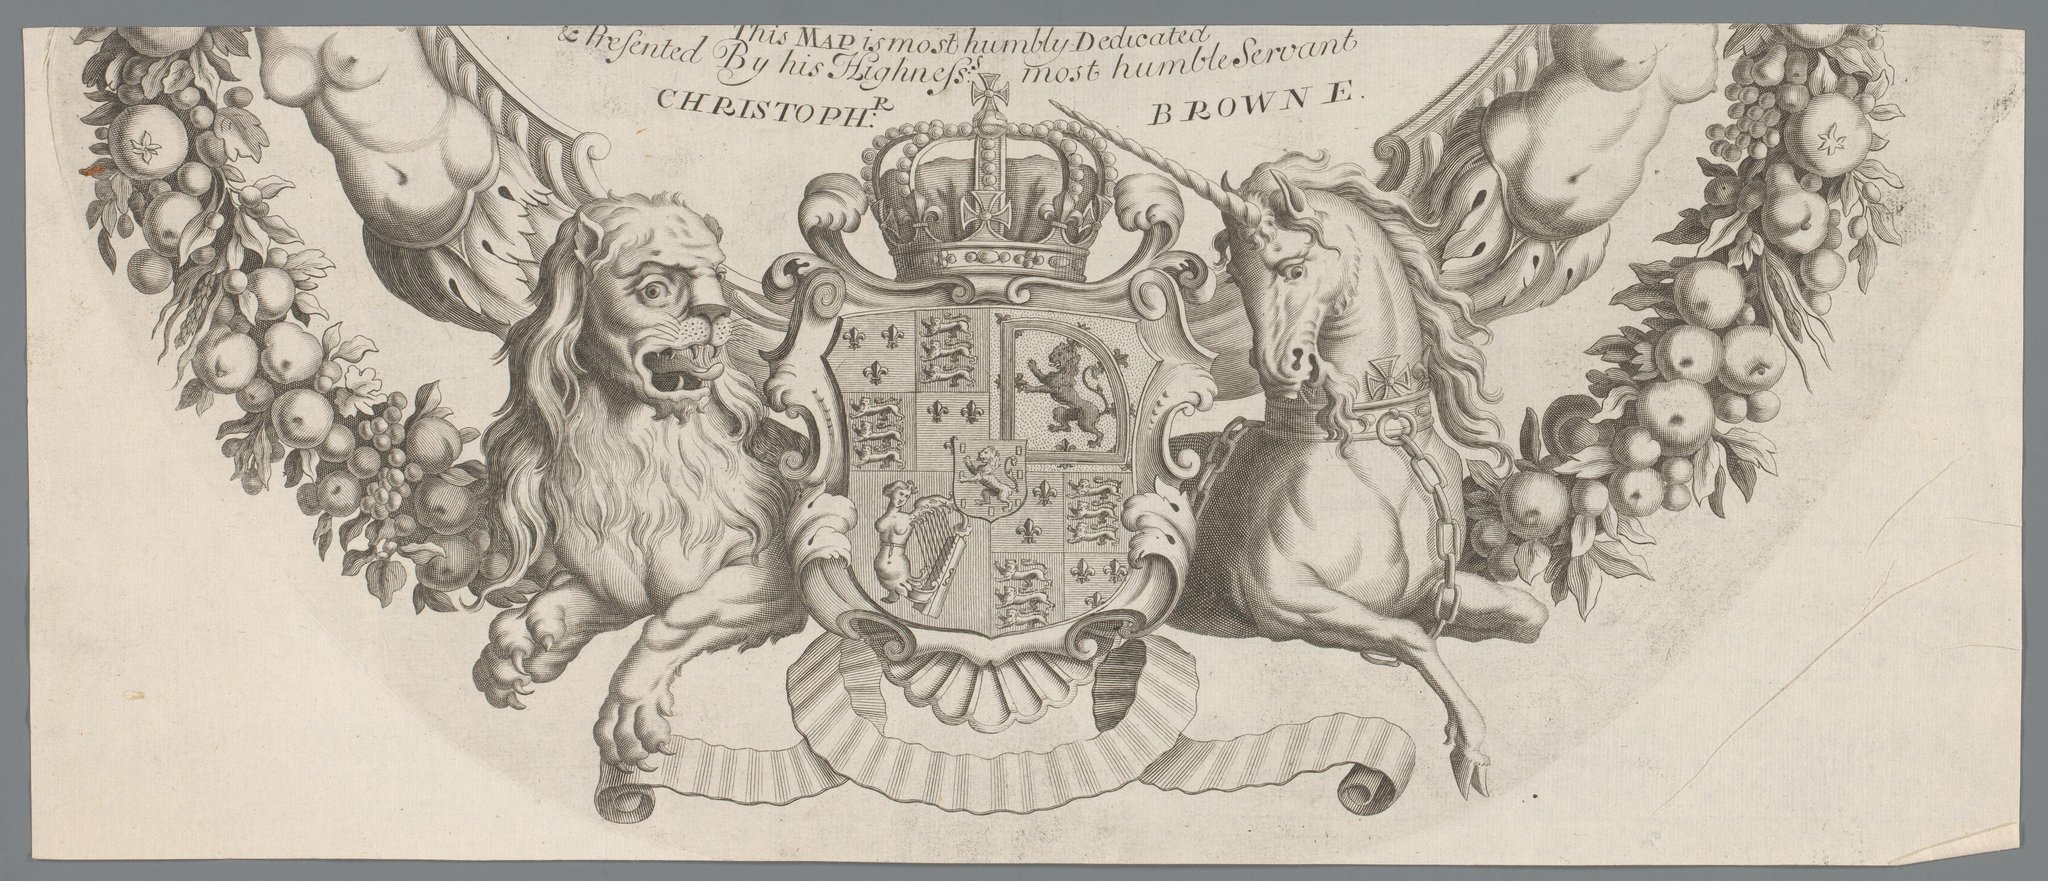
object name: print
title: Wapen van de hertog van Cumberland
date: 1700-1712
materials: paper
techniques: engraving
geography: london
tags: unicorn, beasts of prey, predatory animals: lion (+ heraldic animals), armorial bearing, heraldry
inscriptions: collector's mark: Lugt 2228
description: Wapen afkomstig uit de kaart 'Nova Totius Angluae Tabula / A New Mapp of the Kingdom of England', voor het eerst uitgegeven door Christopher Browne in 1700.